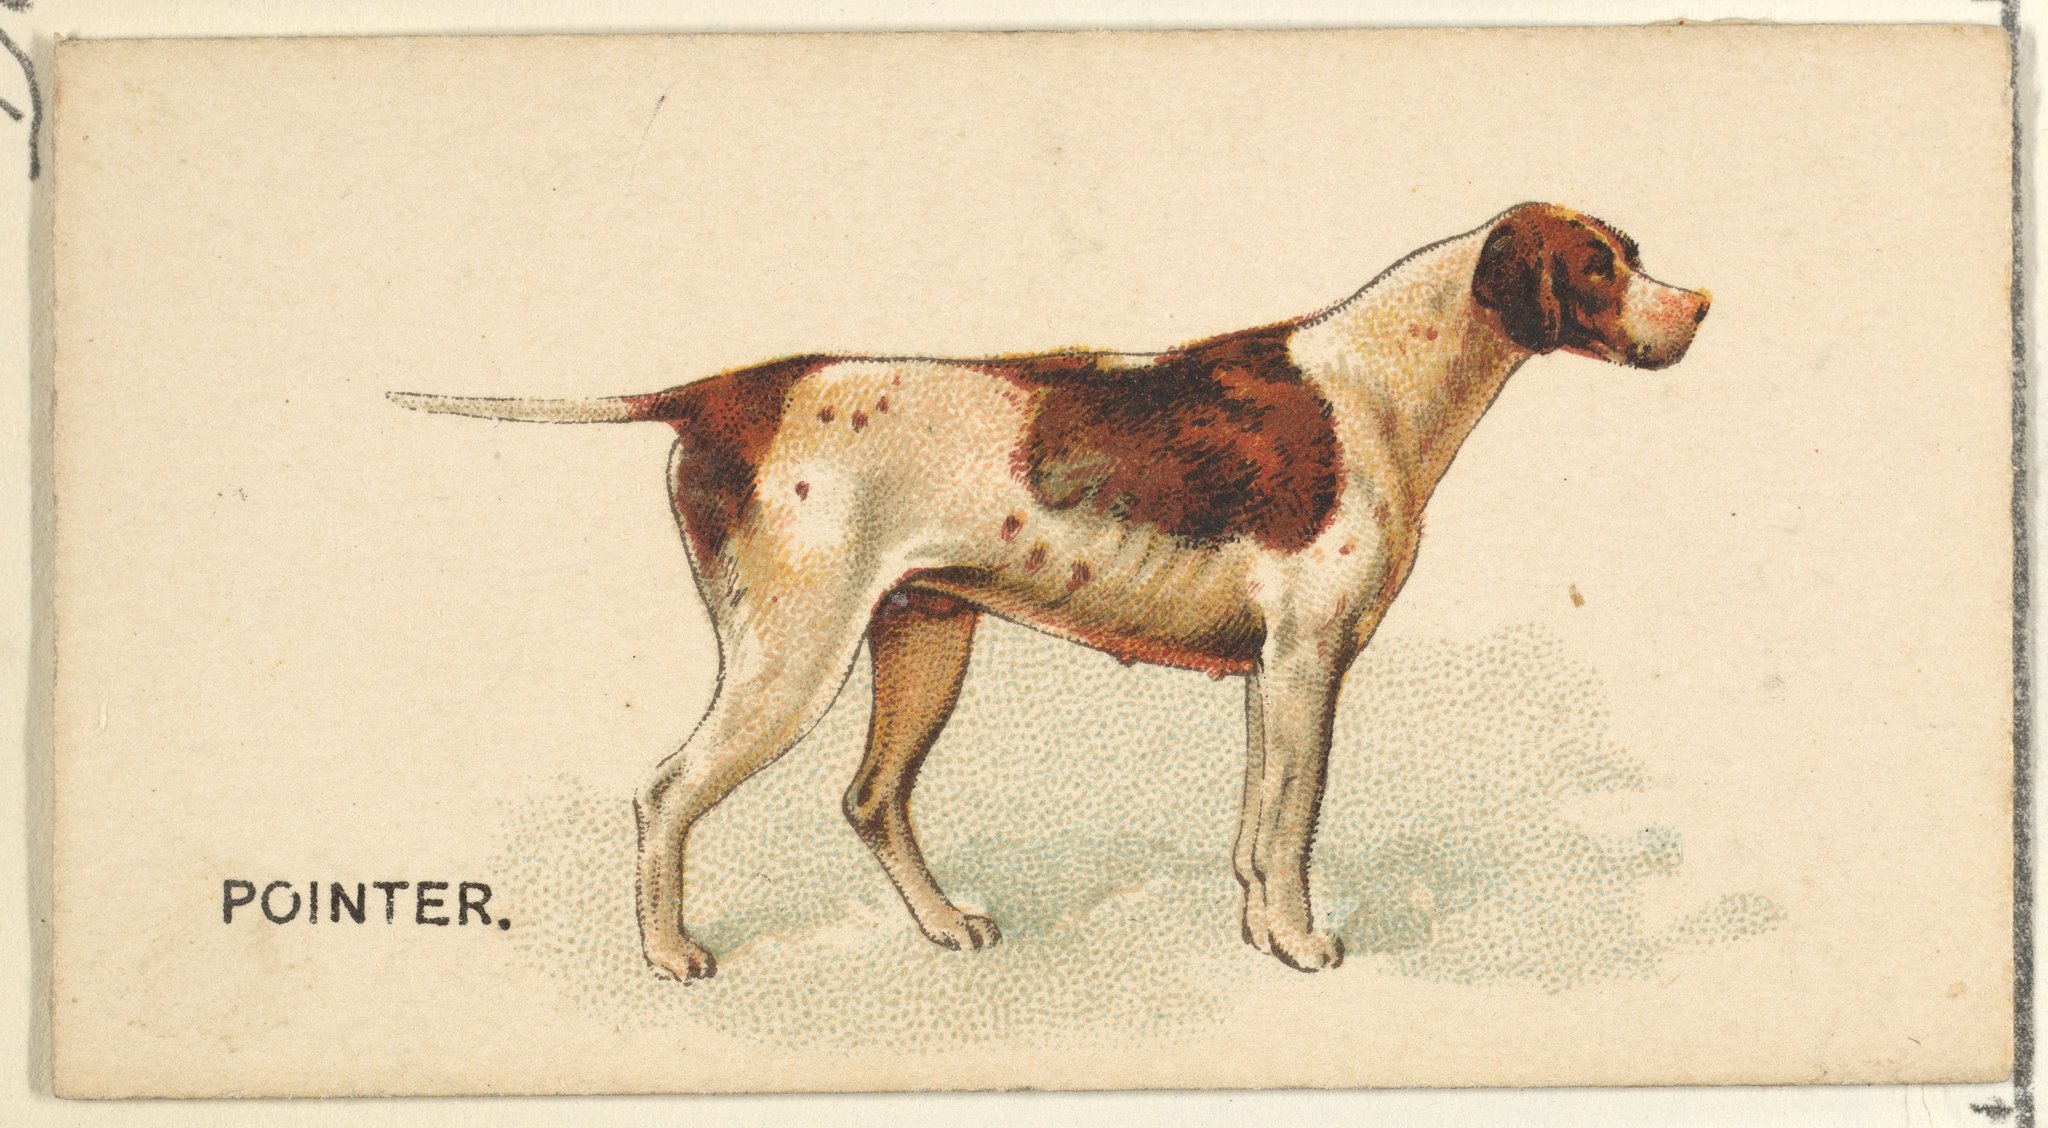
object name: print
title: Pointer, from the Dogs of the World series for Old Judge Cigarettes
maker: goodwin & company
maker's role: publisher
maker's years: 1850-1950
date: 1890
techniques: color lithograph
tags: dogs